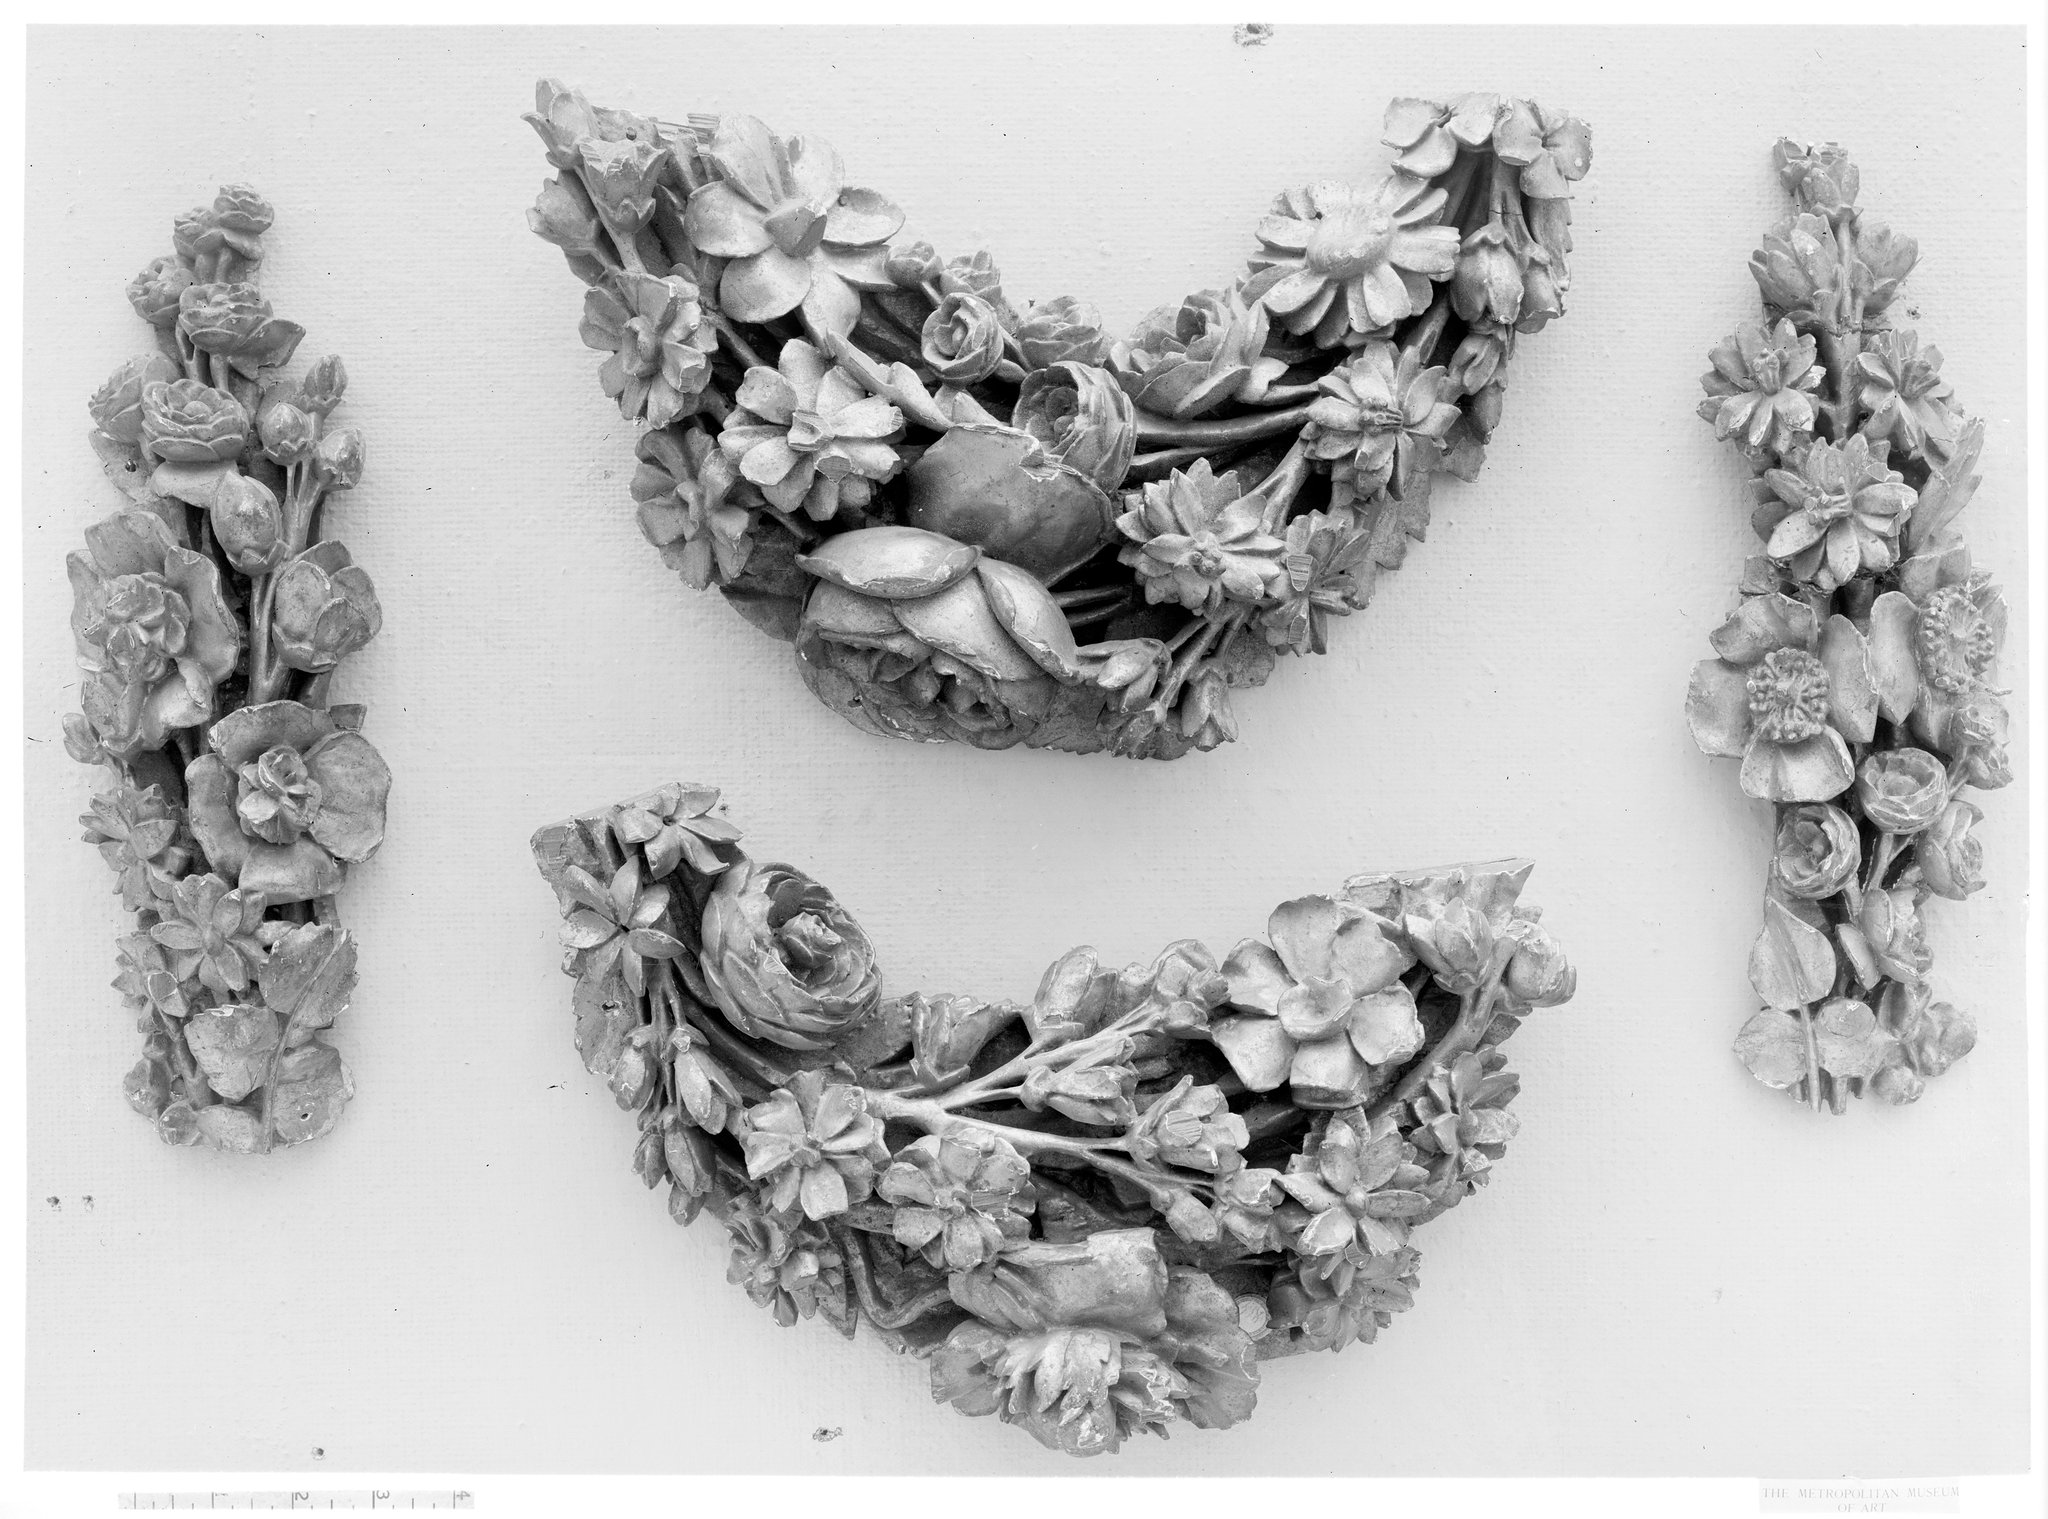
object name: pendant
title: Pendant (part of a set)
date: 1701-1800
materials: gilt, wood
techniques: carving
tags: flowers